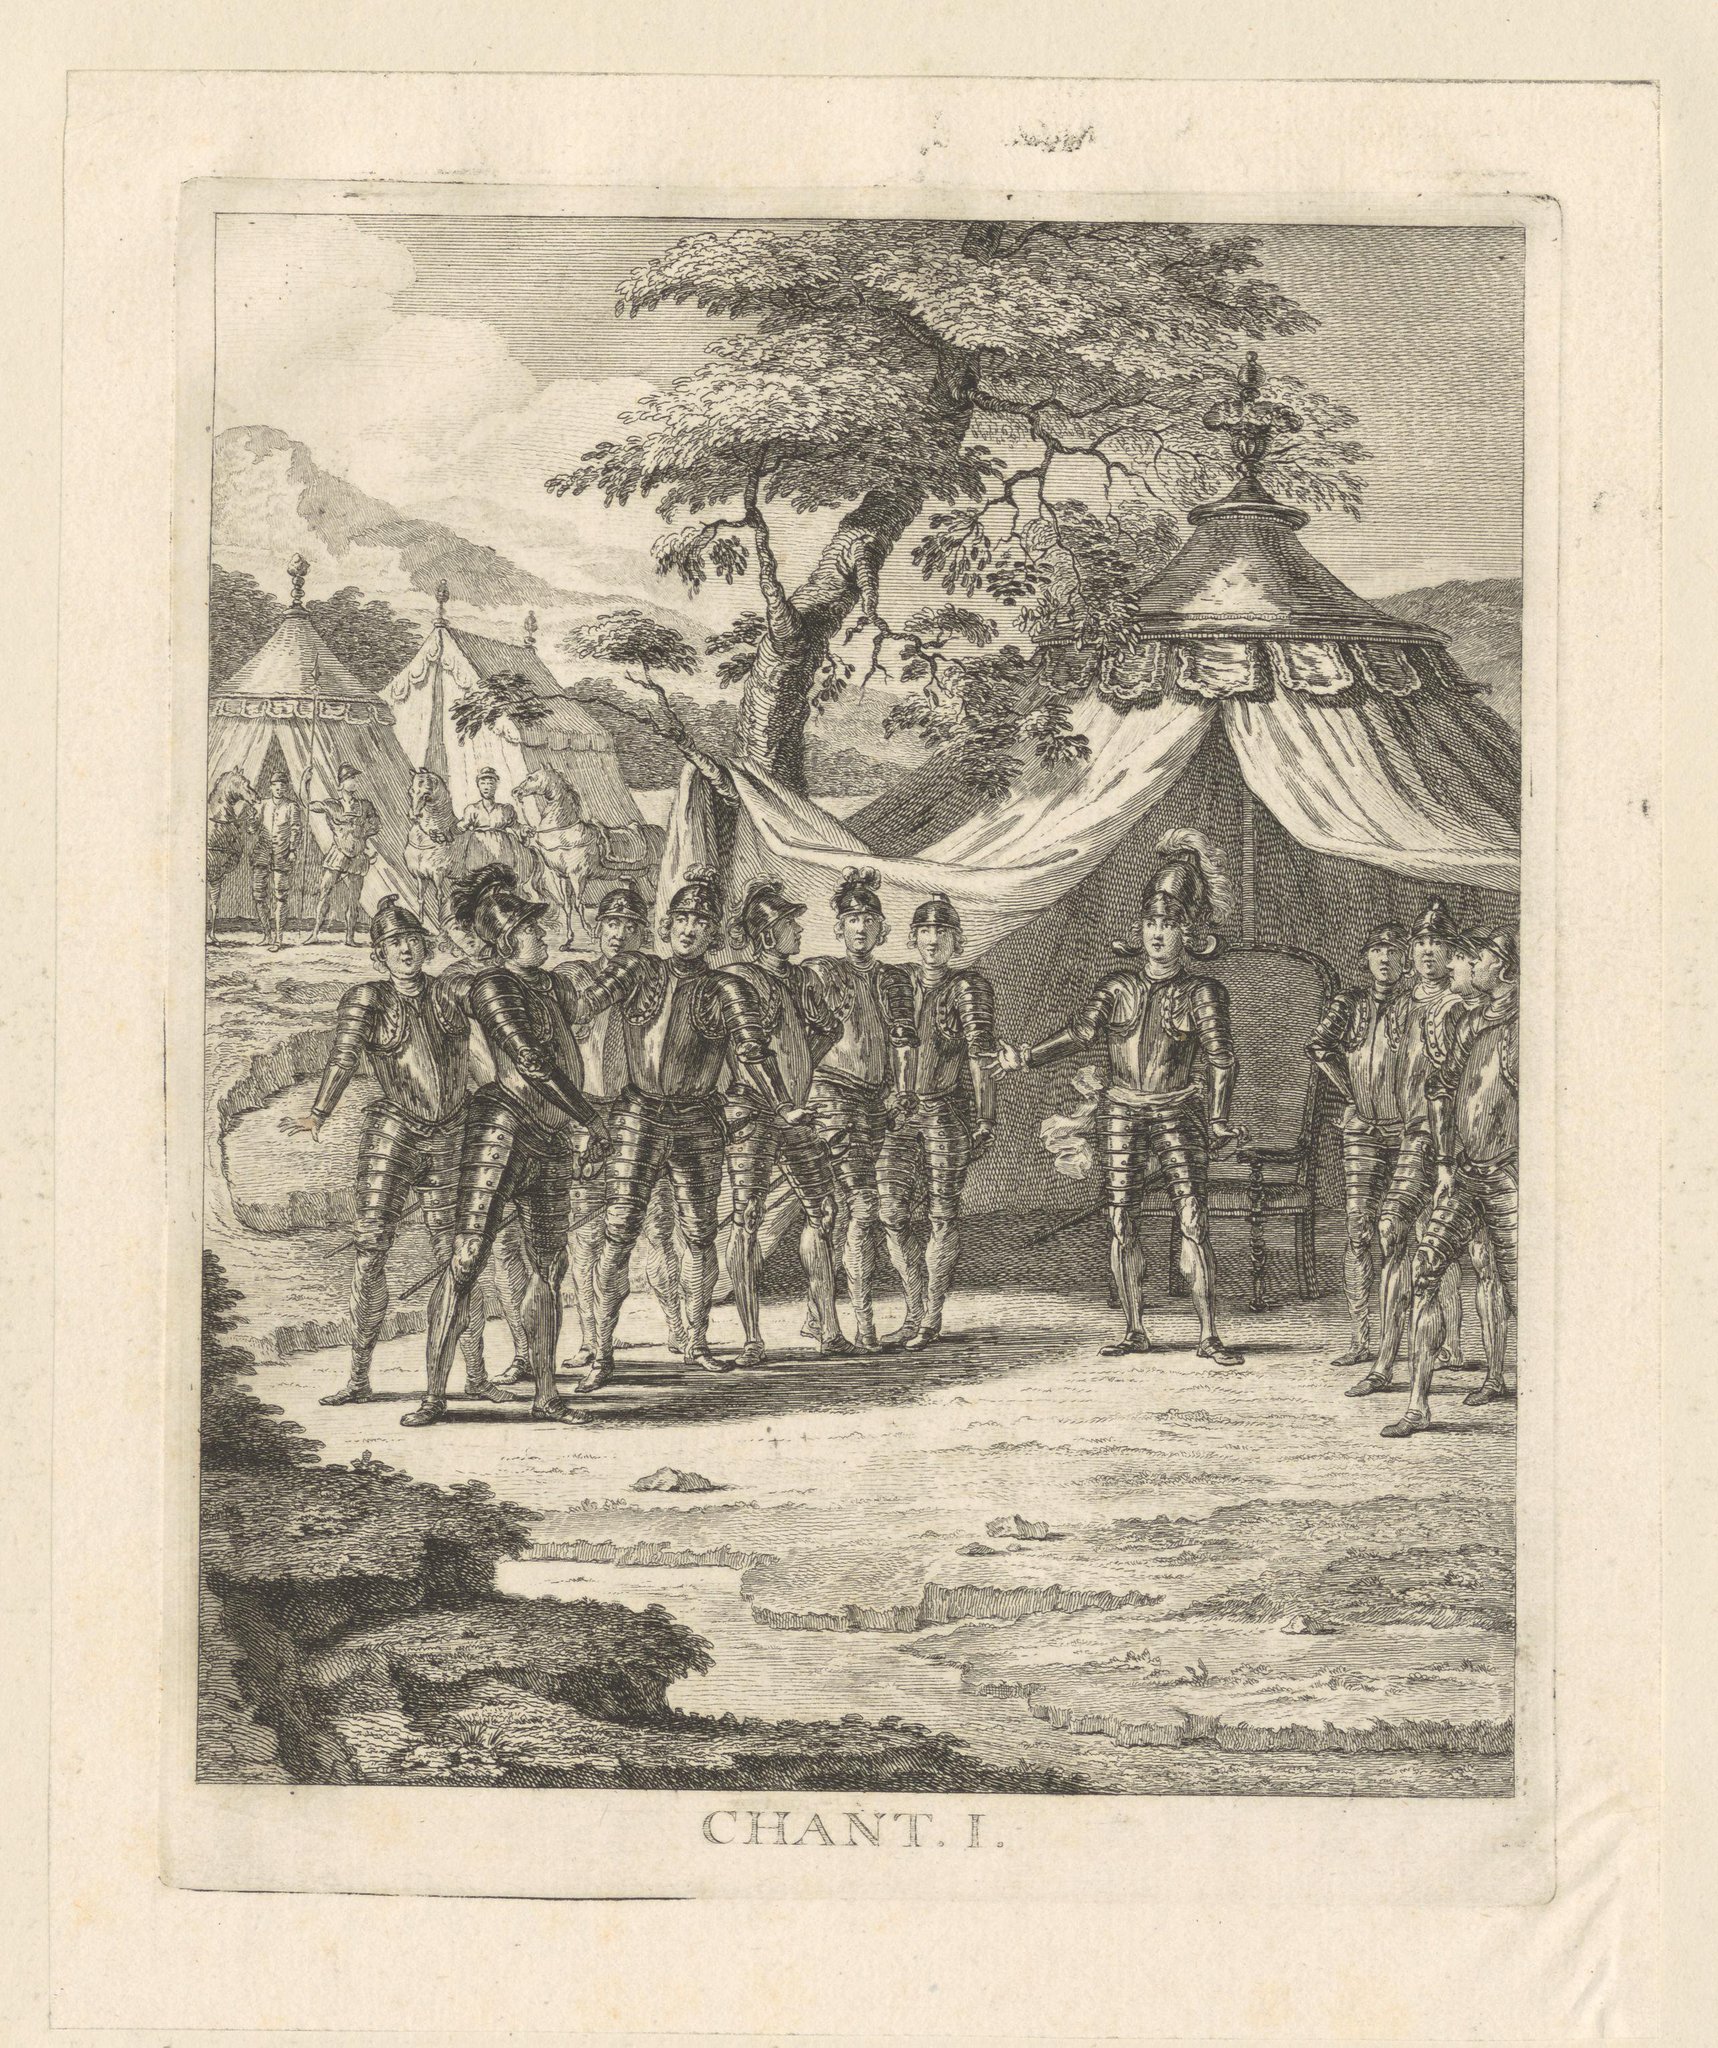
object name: book illustration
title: Geharnaste ridders toegesproken door hun aanvoerder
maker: georg friedrich schmidt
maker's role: draughtsman, print maker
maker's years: 1712-1775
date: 1774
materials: paper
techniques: etching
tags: address by general before the battle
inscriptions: collector's mark: Lugt 240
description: Prent ook gebruikt in: Frederik de Grote. Le Palladium. Sanssouci, Frederik de Grote, 1774.